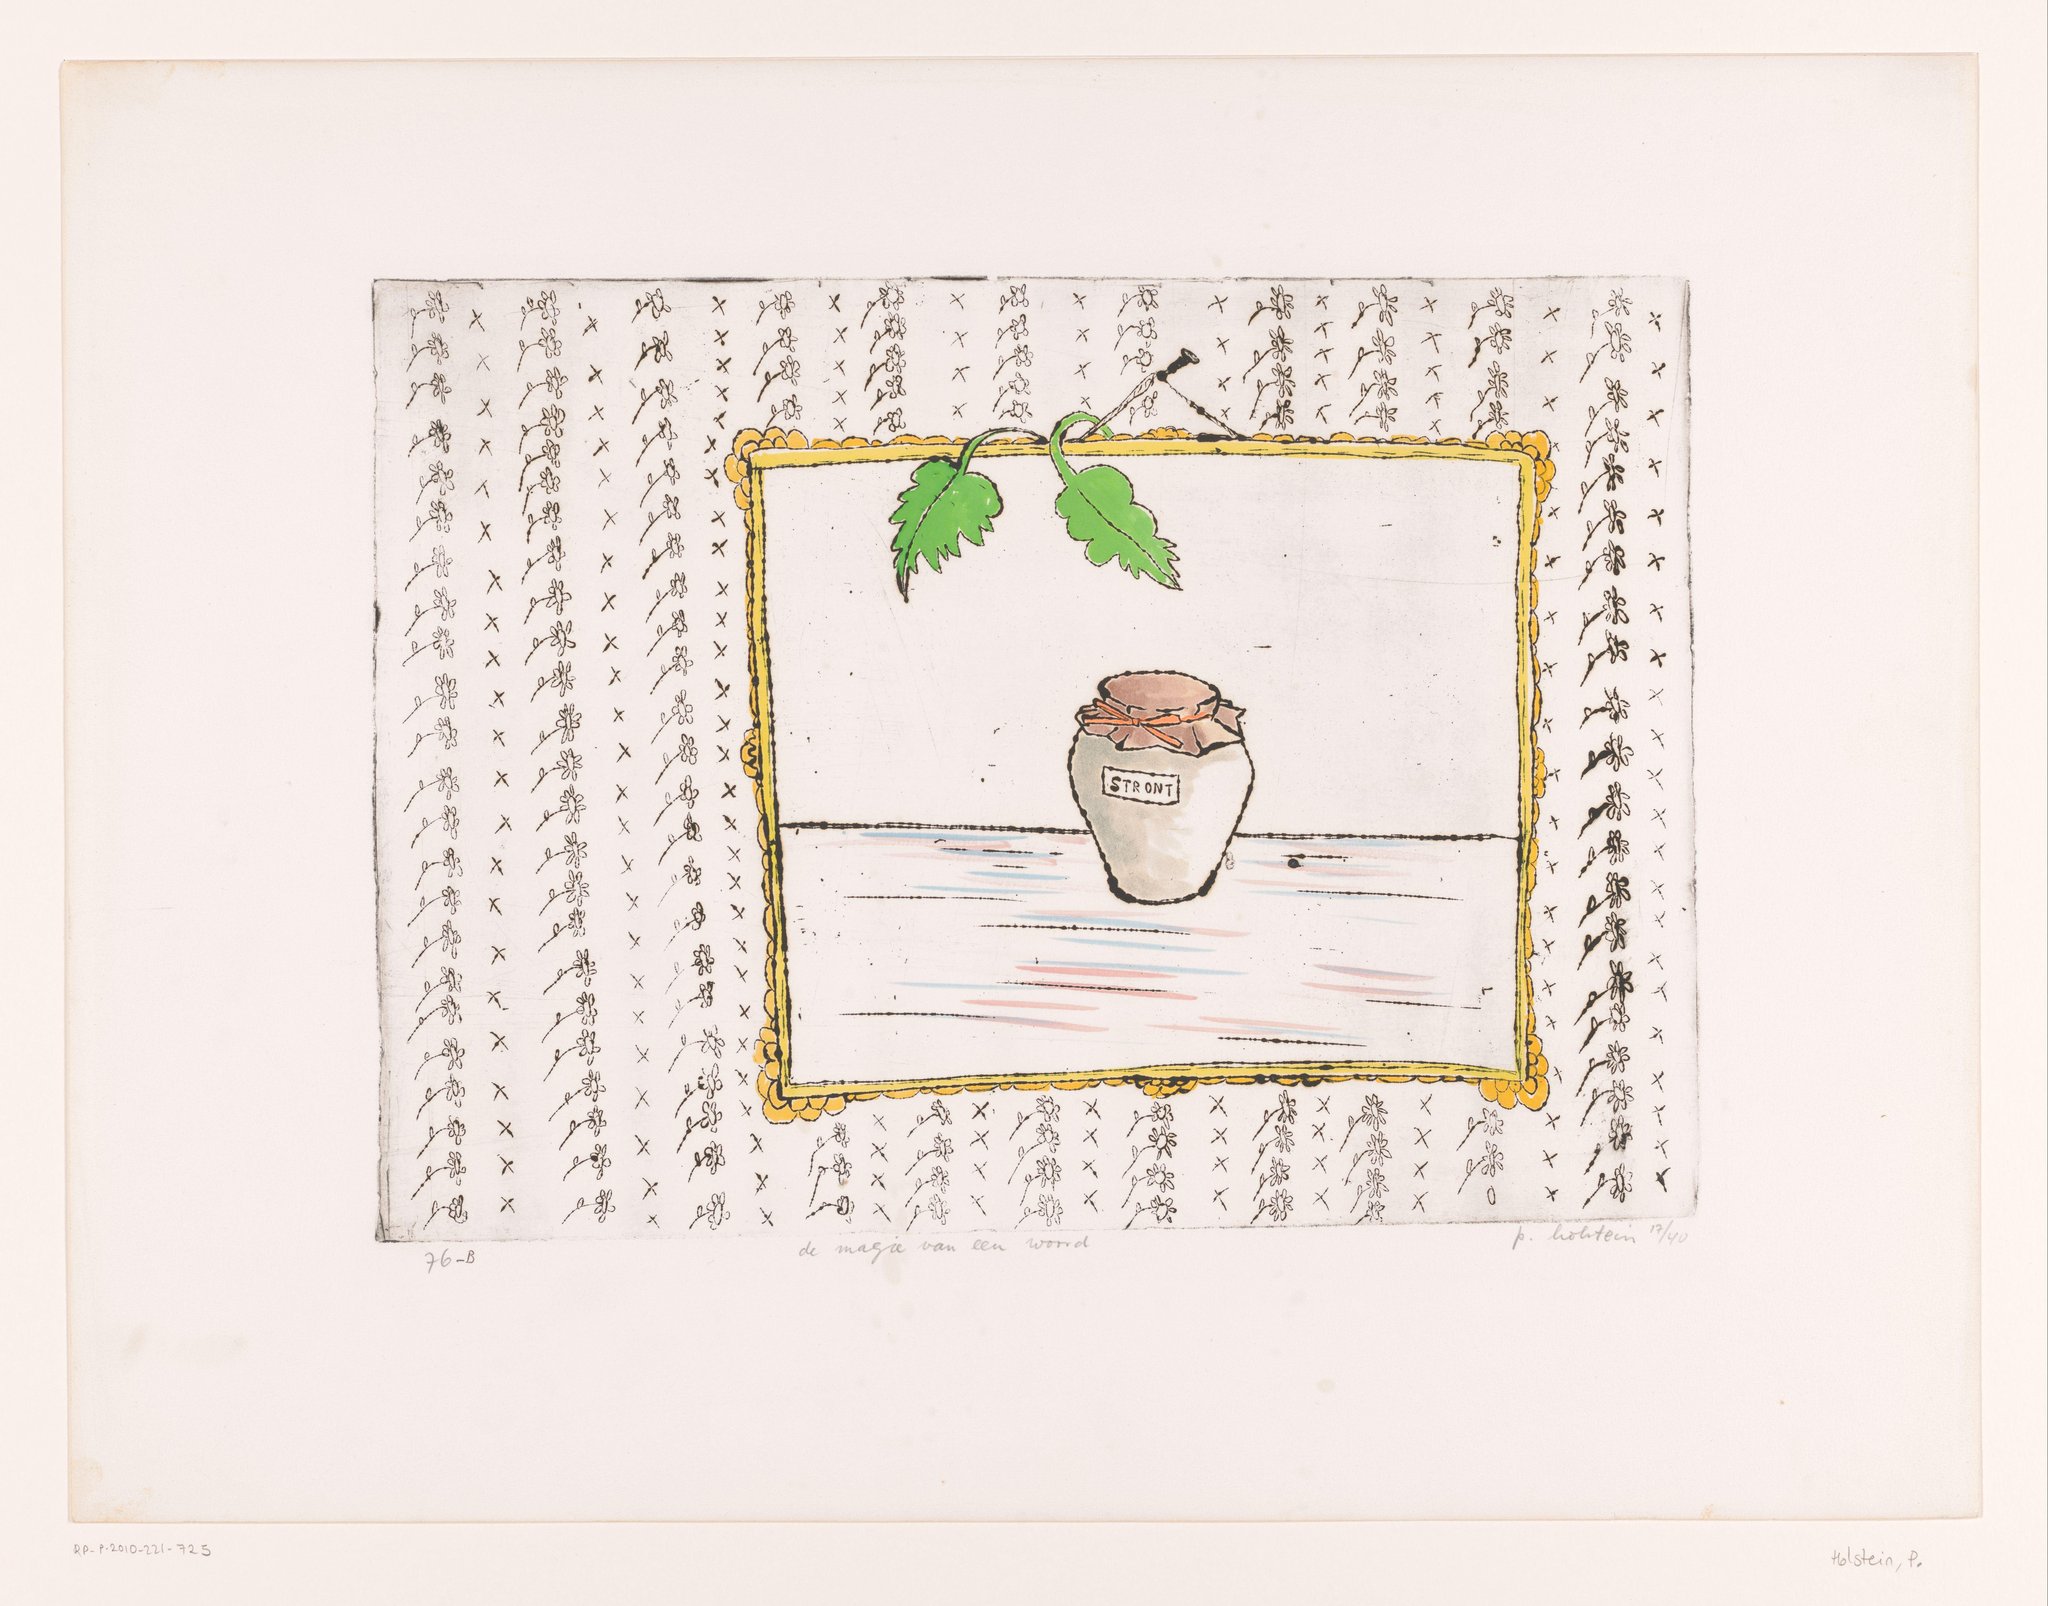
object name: print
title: De magie van een woord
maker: pieter holstein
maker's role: draughtsman, painter, print maker, sculptor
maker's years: 1934-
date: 1969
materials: paper, watercolor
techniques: brush, etching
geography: amsterdam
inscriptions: signature: ‘p. holstein’, title: ‘de magie van een woord’, edition: ‘17/40’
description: Glazen pot waar men jam in zou verwachten met als opschrift 'Stront', op schilderij dat aan een muur hangt met gebloemd behang.